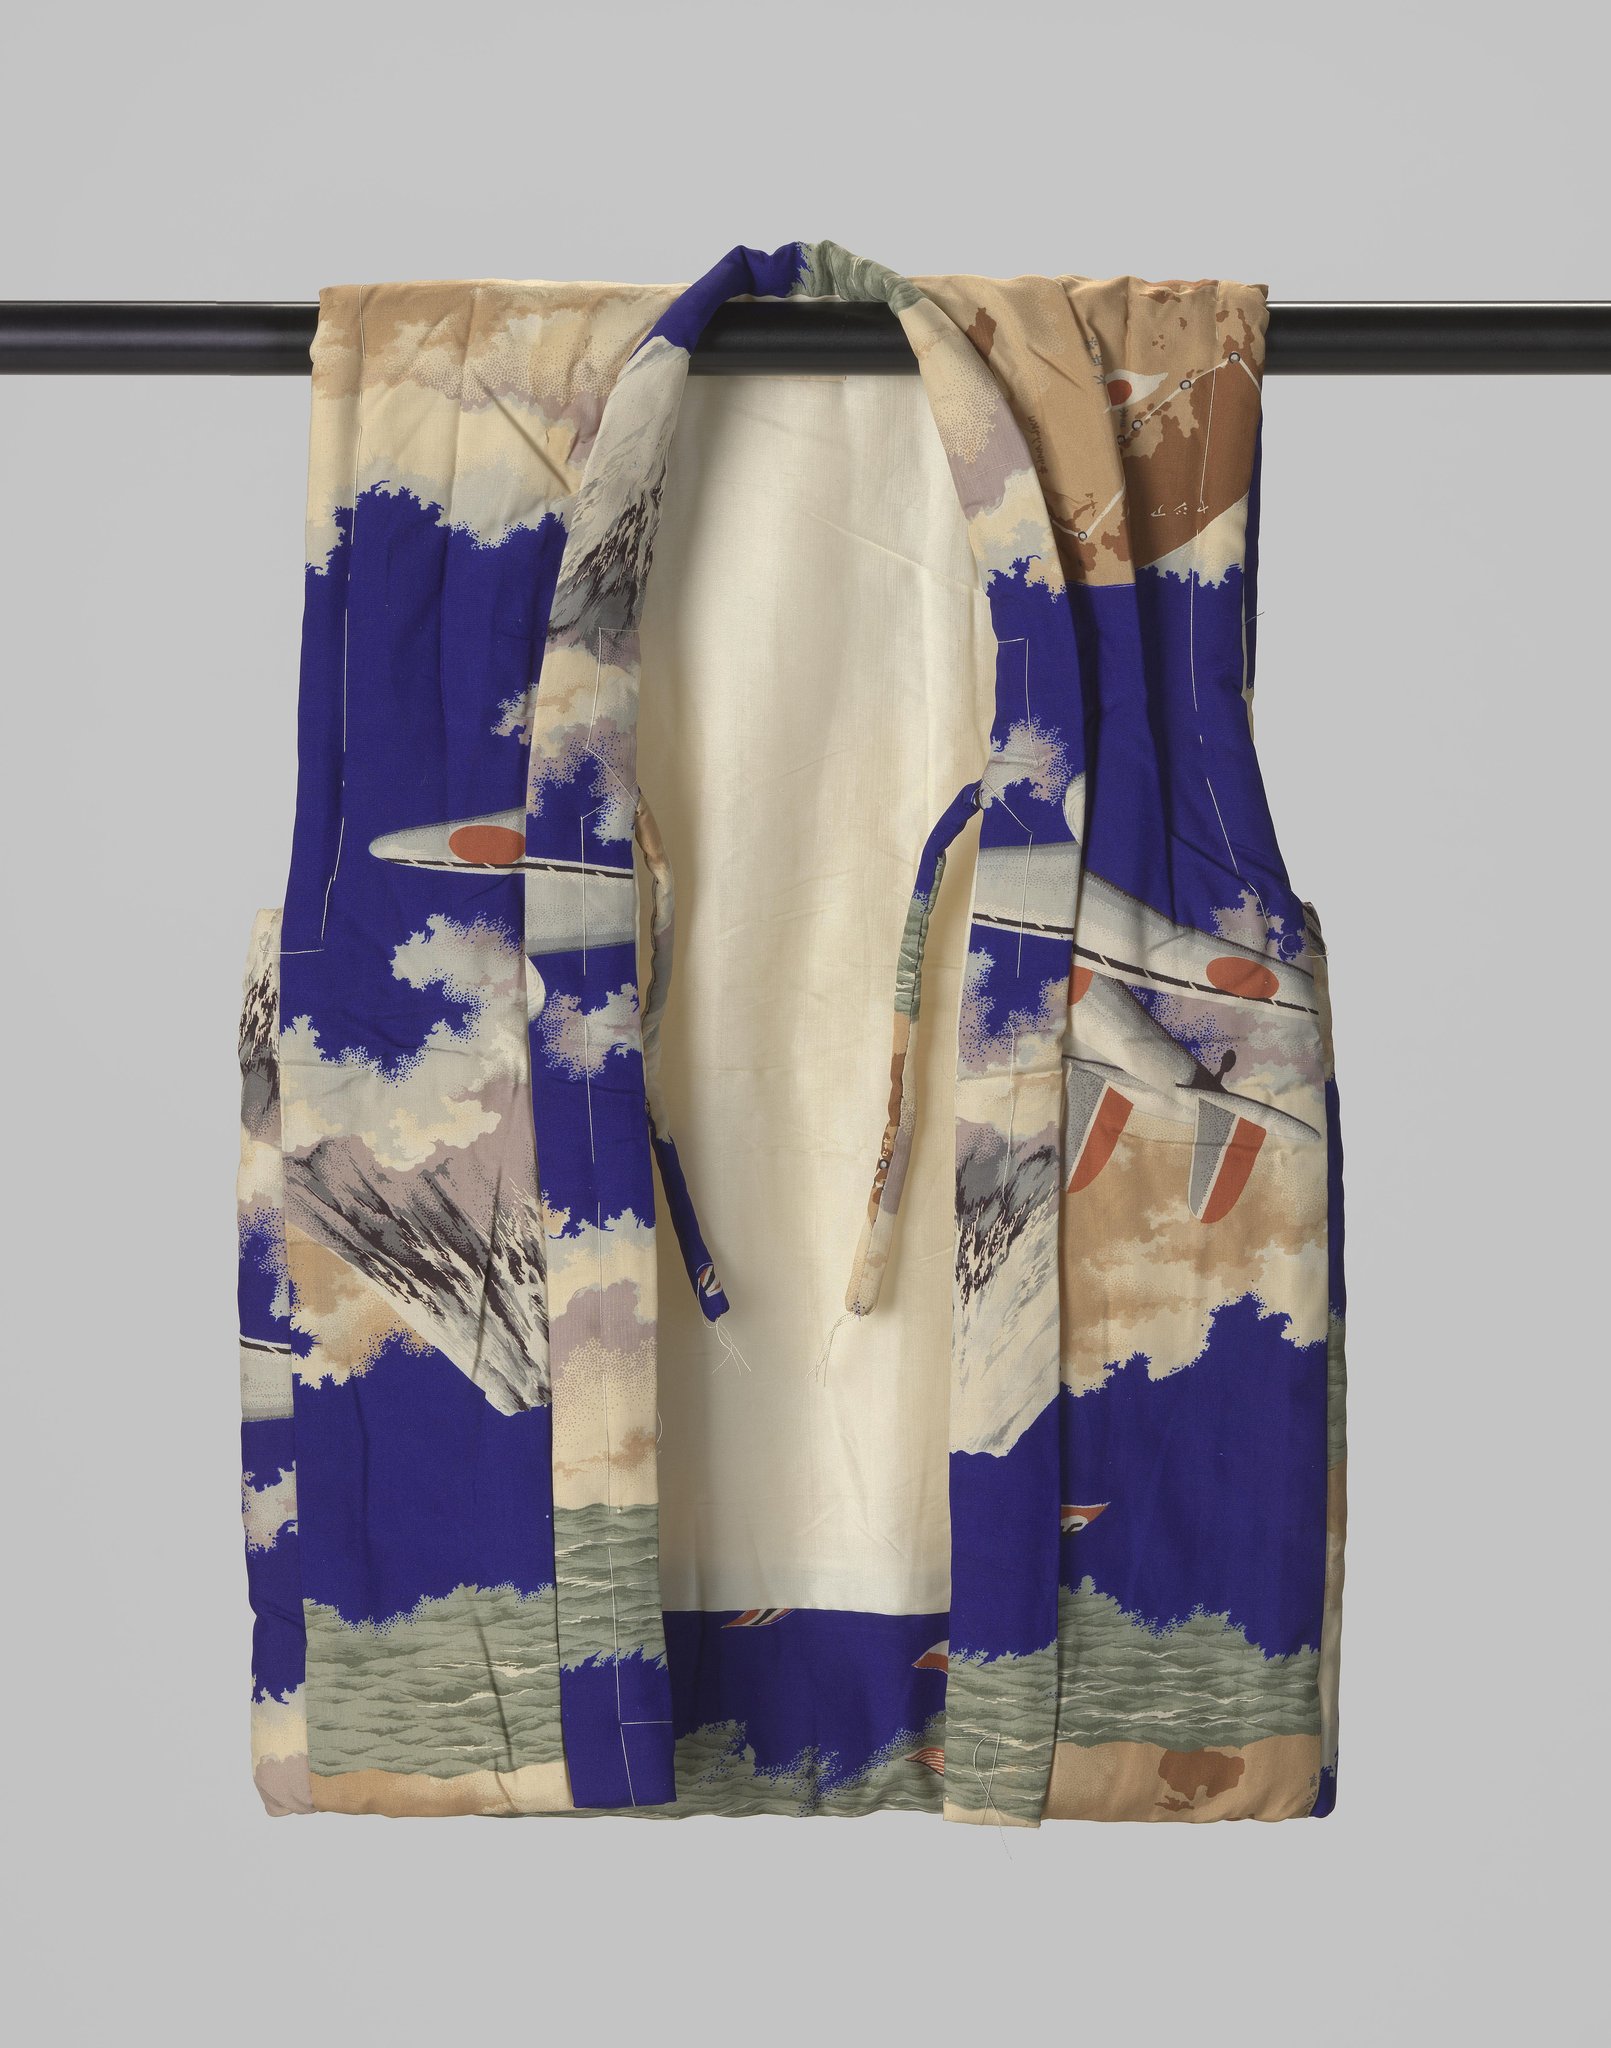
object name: jasje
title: Kinderjasje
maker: Anonymous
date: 1939-1945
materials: ink, silk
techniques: colors on silk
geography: japan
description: Een gewatteerd kinderjasje met een voorstelling van een vliegtuig, de berg Fuji en een wereldbol. Het verbeeldt de vlucht rond de wereld door de Nippon (Mitsubishi G3M2 Model 21), uitgevoerd door de krant Mainichi Shimbun, van 25 augustus tot 20 oktober 1939.